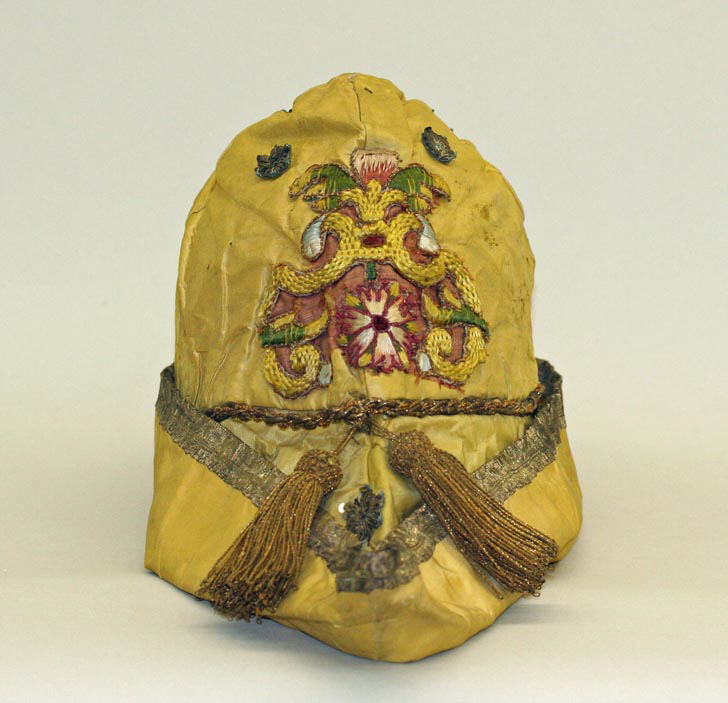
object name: hat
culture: italian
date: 1501-1600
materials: metal thread, silk